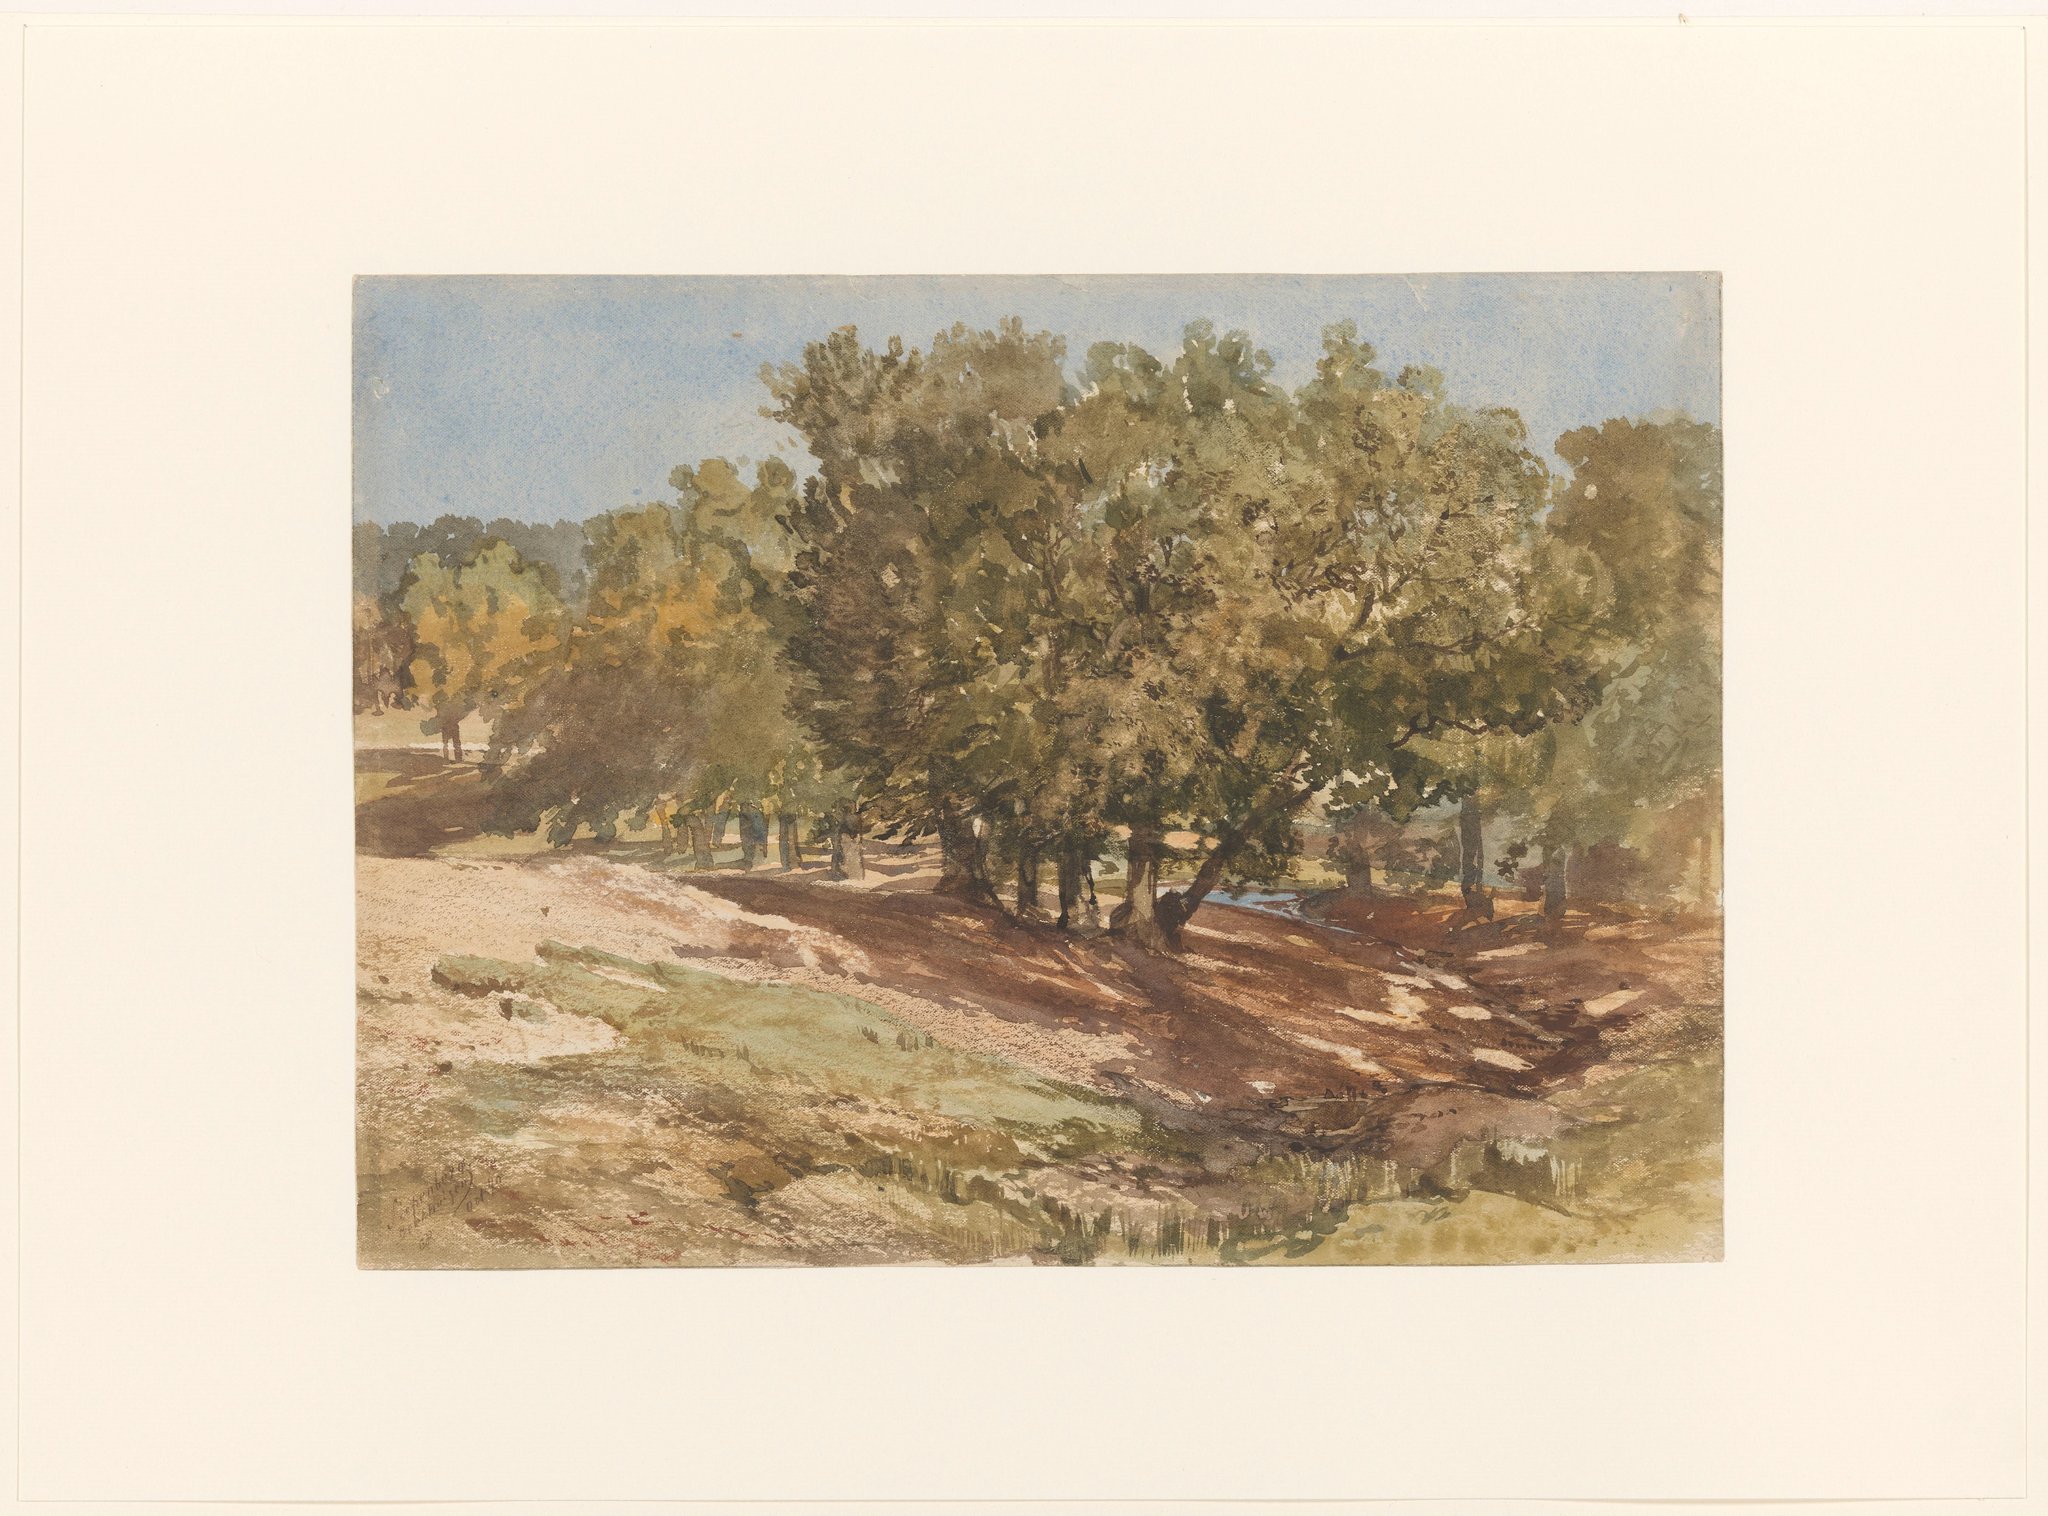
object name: drawing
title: Gezicht te Beekhuizen, op de Zijpenberg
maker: charles rochussen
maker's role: draughtsman, painter, print maker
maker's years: 1814-1894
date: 1810-1840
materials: paper, watercolor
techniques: brush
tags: low hill country